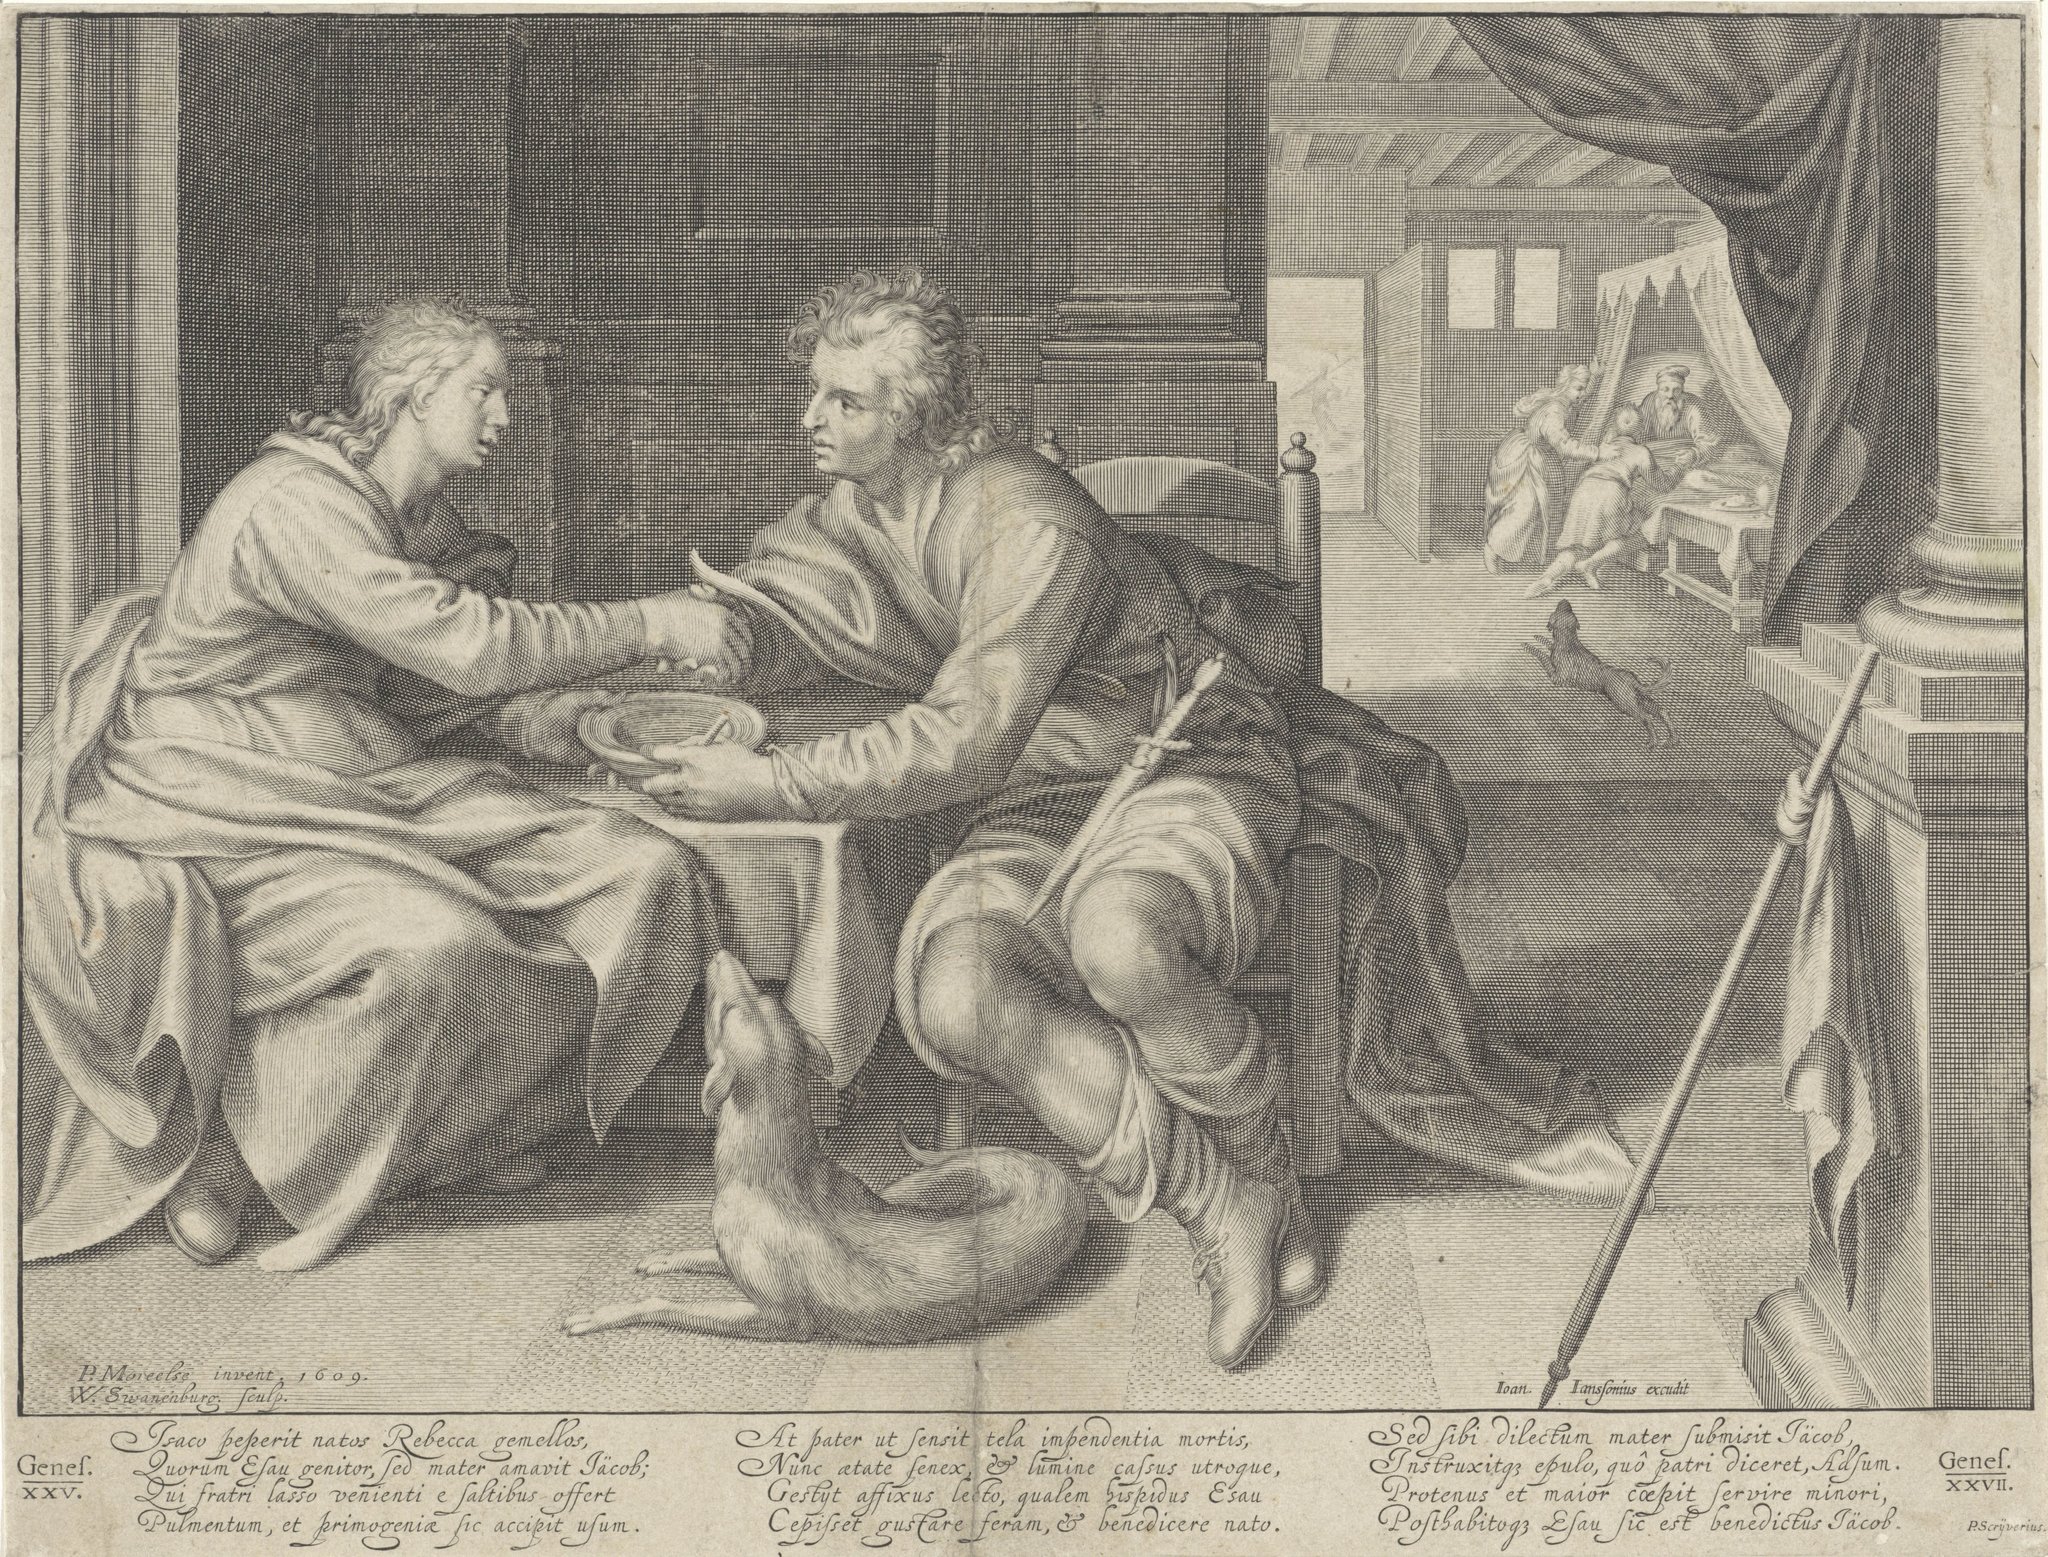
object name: print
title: Esau verkoopt zijn eerstgeboorterecht aan Jakob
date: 1609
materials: paper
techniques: engraving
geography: amsterdam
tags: esau, returning hungry from the hunt, sells his first birthright to jacob for a pottage of lentils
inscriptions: collector's mark: Lugt 2228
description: Jakob en Esau zitten aan tafel en schudden elkaars hand boven een kom met linzen. Bij hun voeten ligt een hond. Rechts in de verte knielt een man bij het bed van Abraham. Onder de voorstelling bevindt zich een twaalfregelige, Latijnse tekst uit Genesis 25-27.